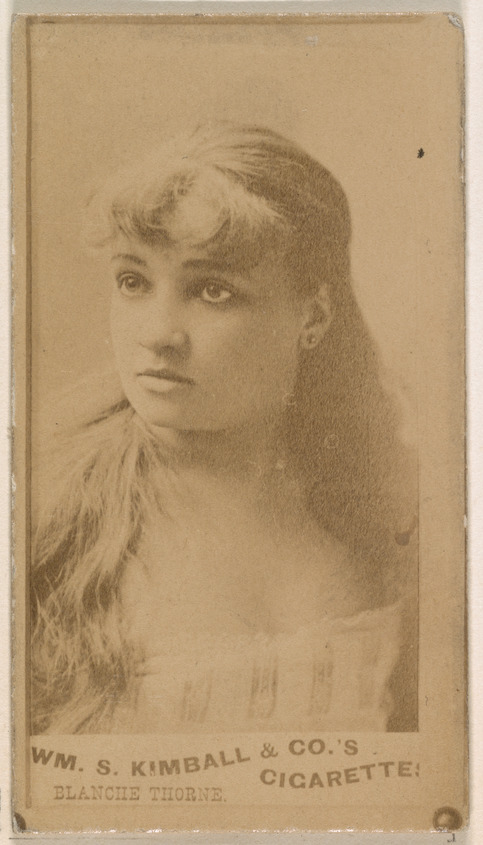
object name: photograph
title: Blanche Thorne, from the Actresses series (N203) issued by Wm. S. Kimball & Co.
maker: william s. kimball & company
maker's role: publisher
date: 1889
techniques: color lithograph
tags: portraits,women,actresses